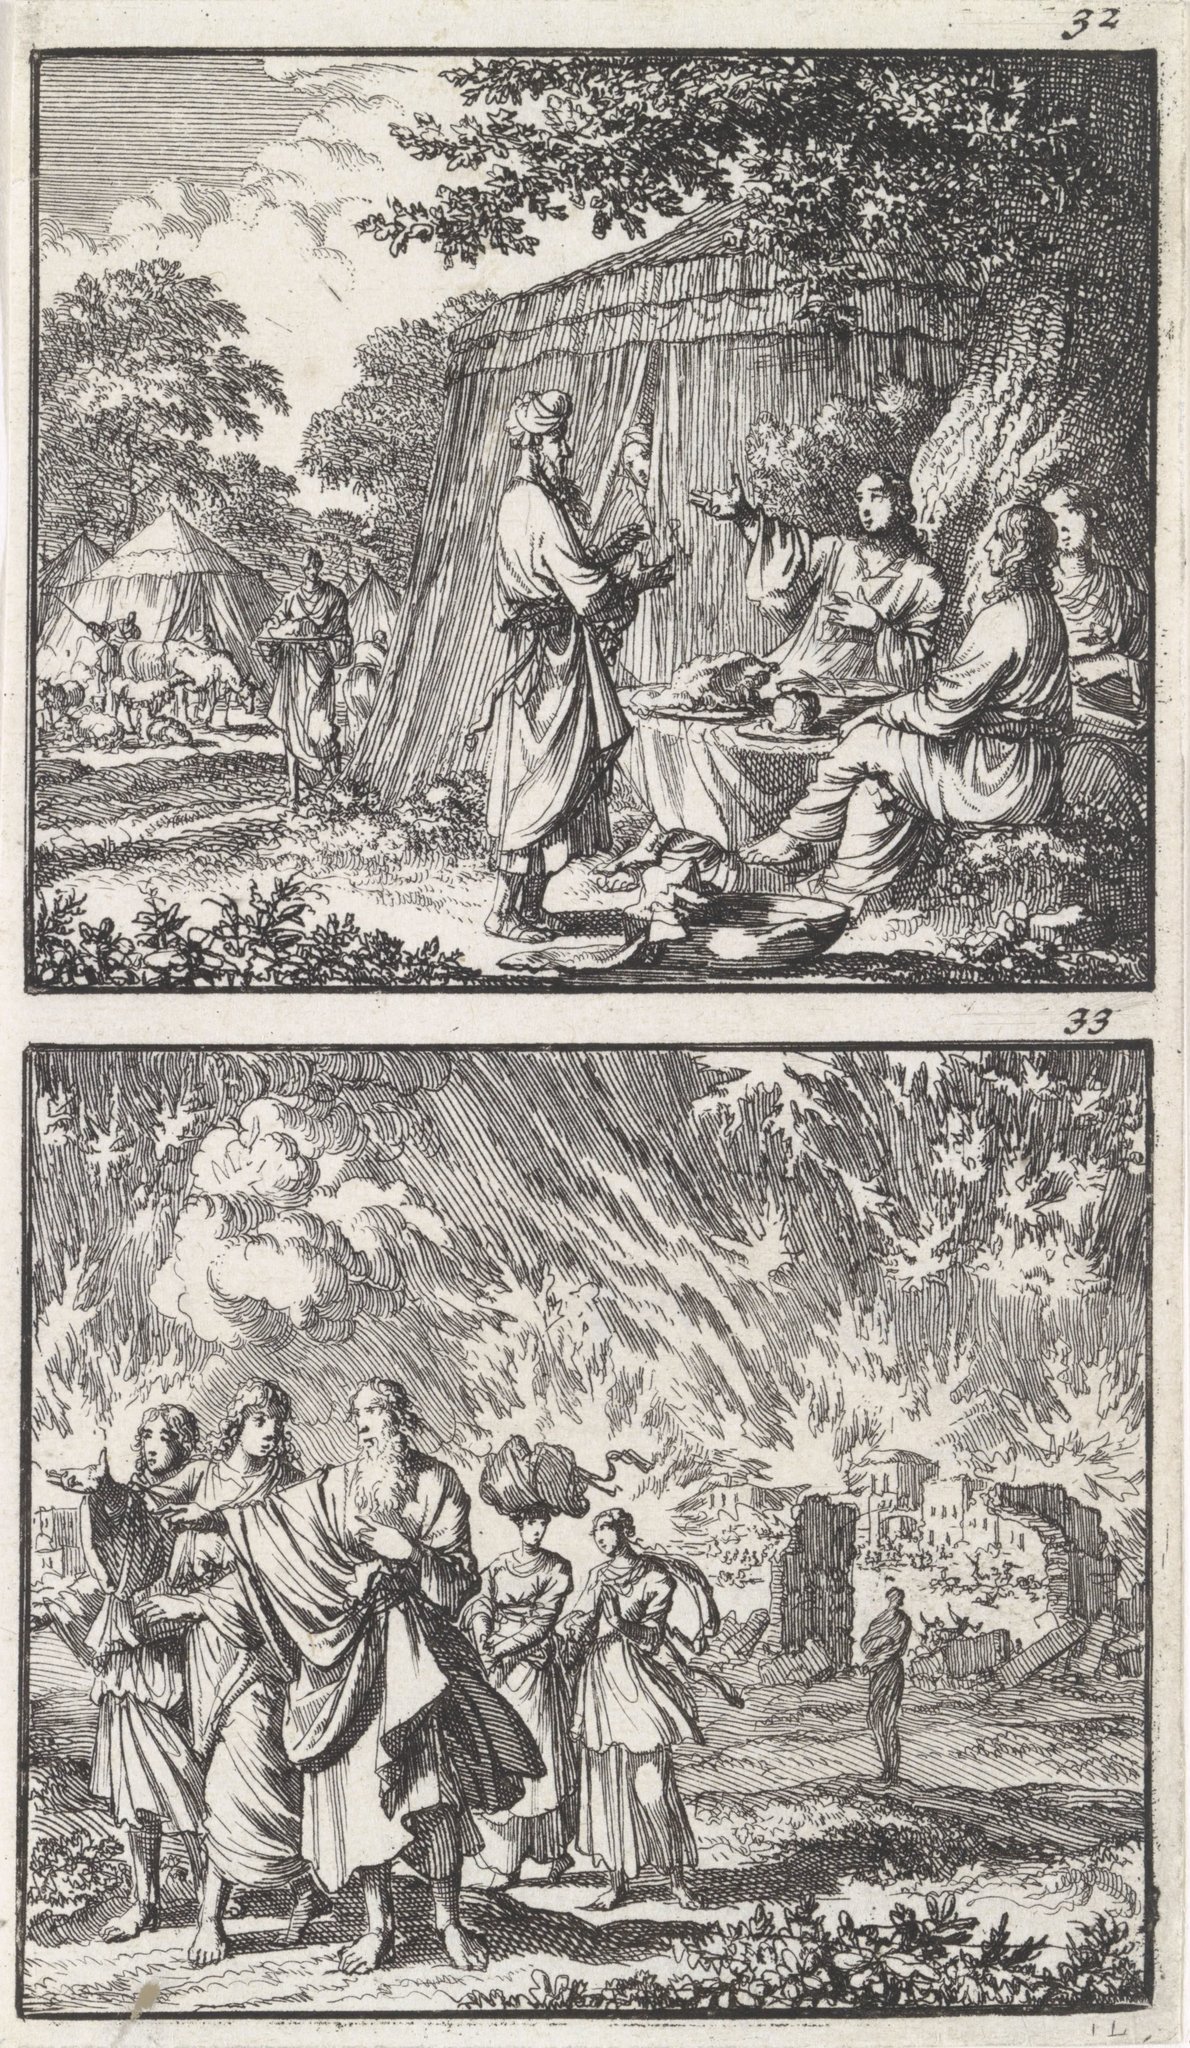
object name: print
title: Abraham ontvangt de drie engelen / Lot verlaat Sodom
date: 1698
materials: paper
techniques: etching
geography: amsterdam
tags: the visit of the three angels (three men) ~ story of abraham (genesis 18), the destruction of sodom and gomorrah: lot and his family flee to zoar, carrying their belongings; an angel may be showing the way (genesis 19:24-29)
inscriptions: collector's mark: Lugt 2228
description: Illustraties uit: Josephus, Flavius. XX. boeken van de oude geschiedenissen der joden, 4 delen. Amsterdam: Barent Visscher, Willem de Coup, Willem van Lamsveld, Andries van Damme, 1698, dl. I.